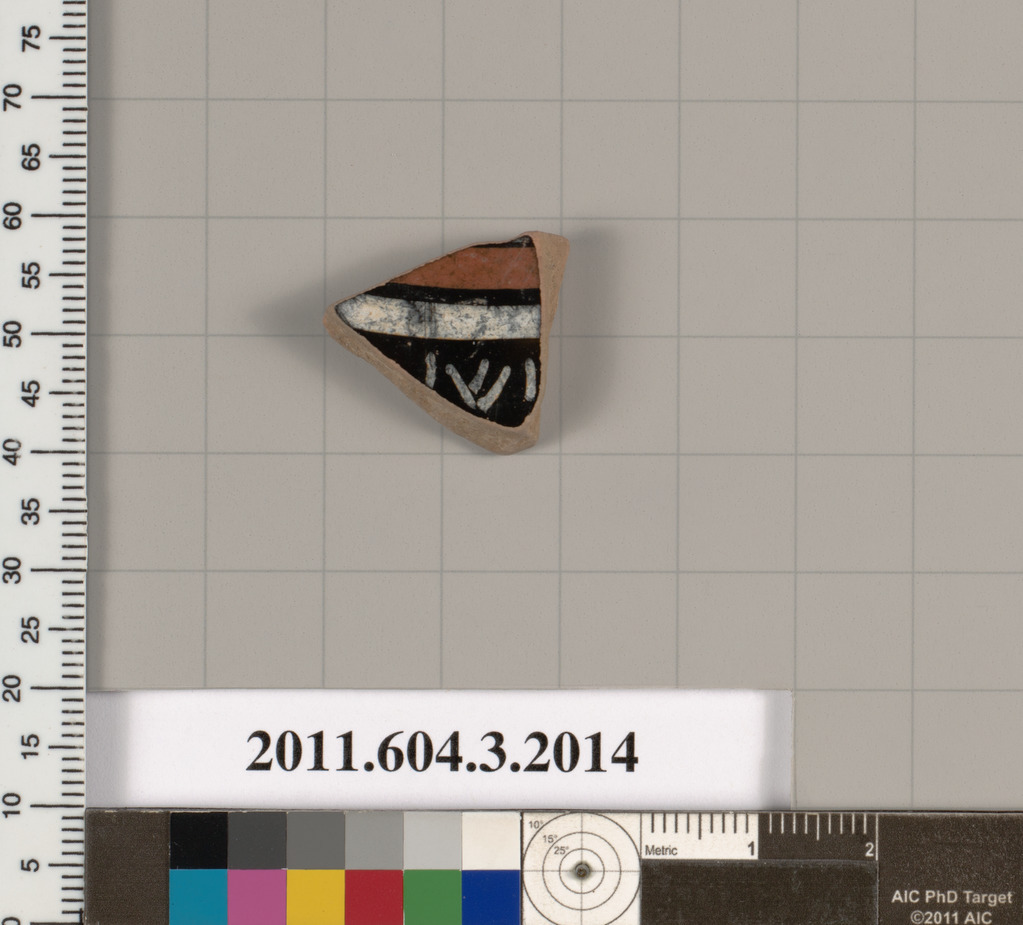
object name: kylix fragment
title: Terracotta fragment of a kylix (drinking cup)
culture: greek, attic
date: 550-526 BCE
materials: terracotta